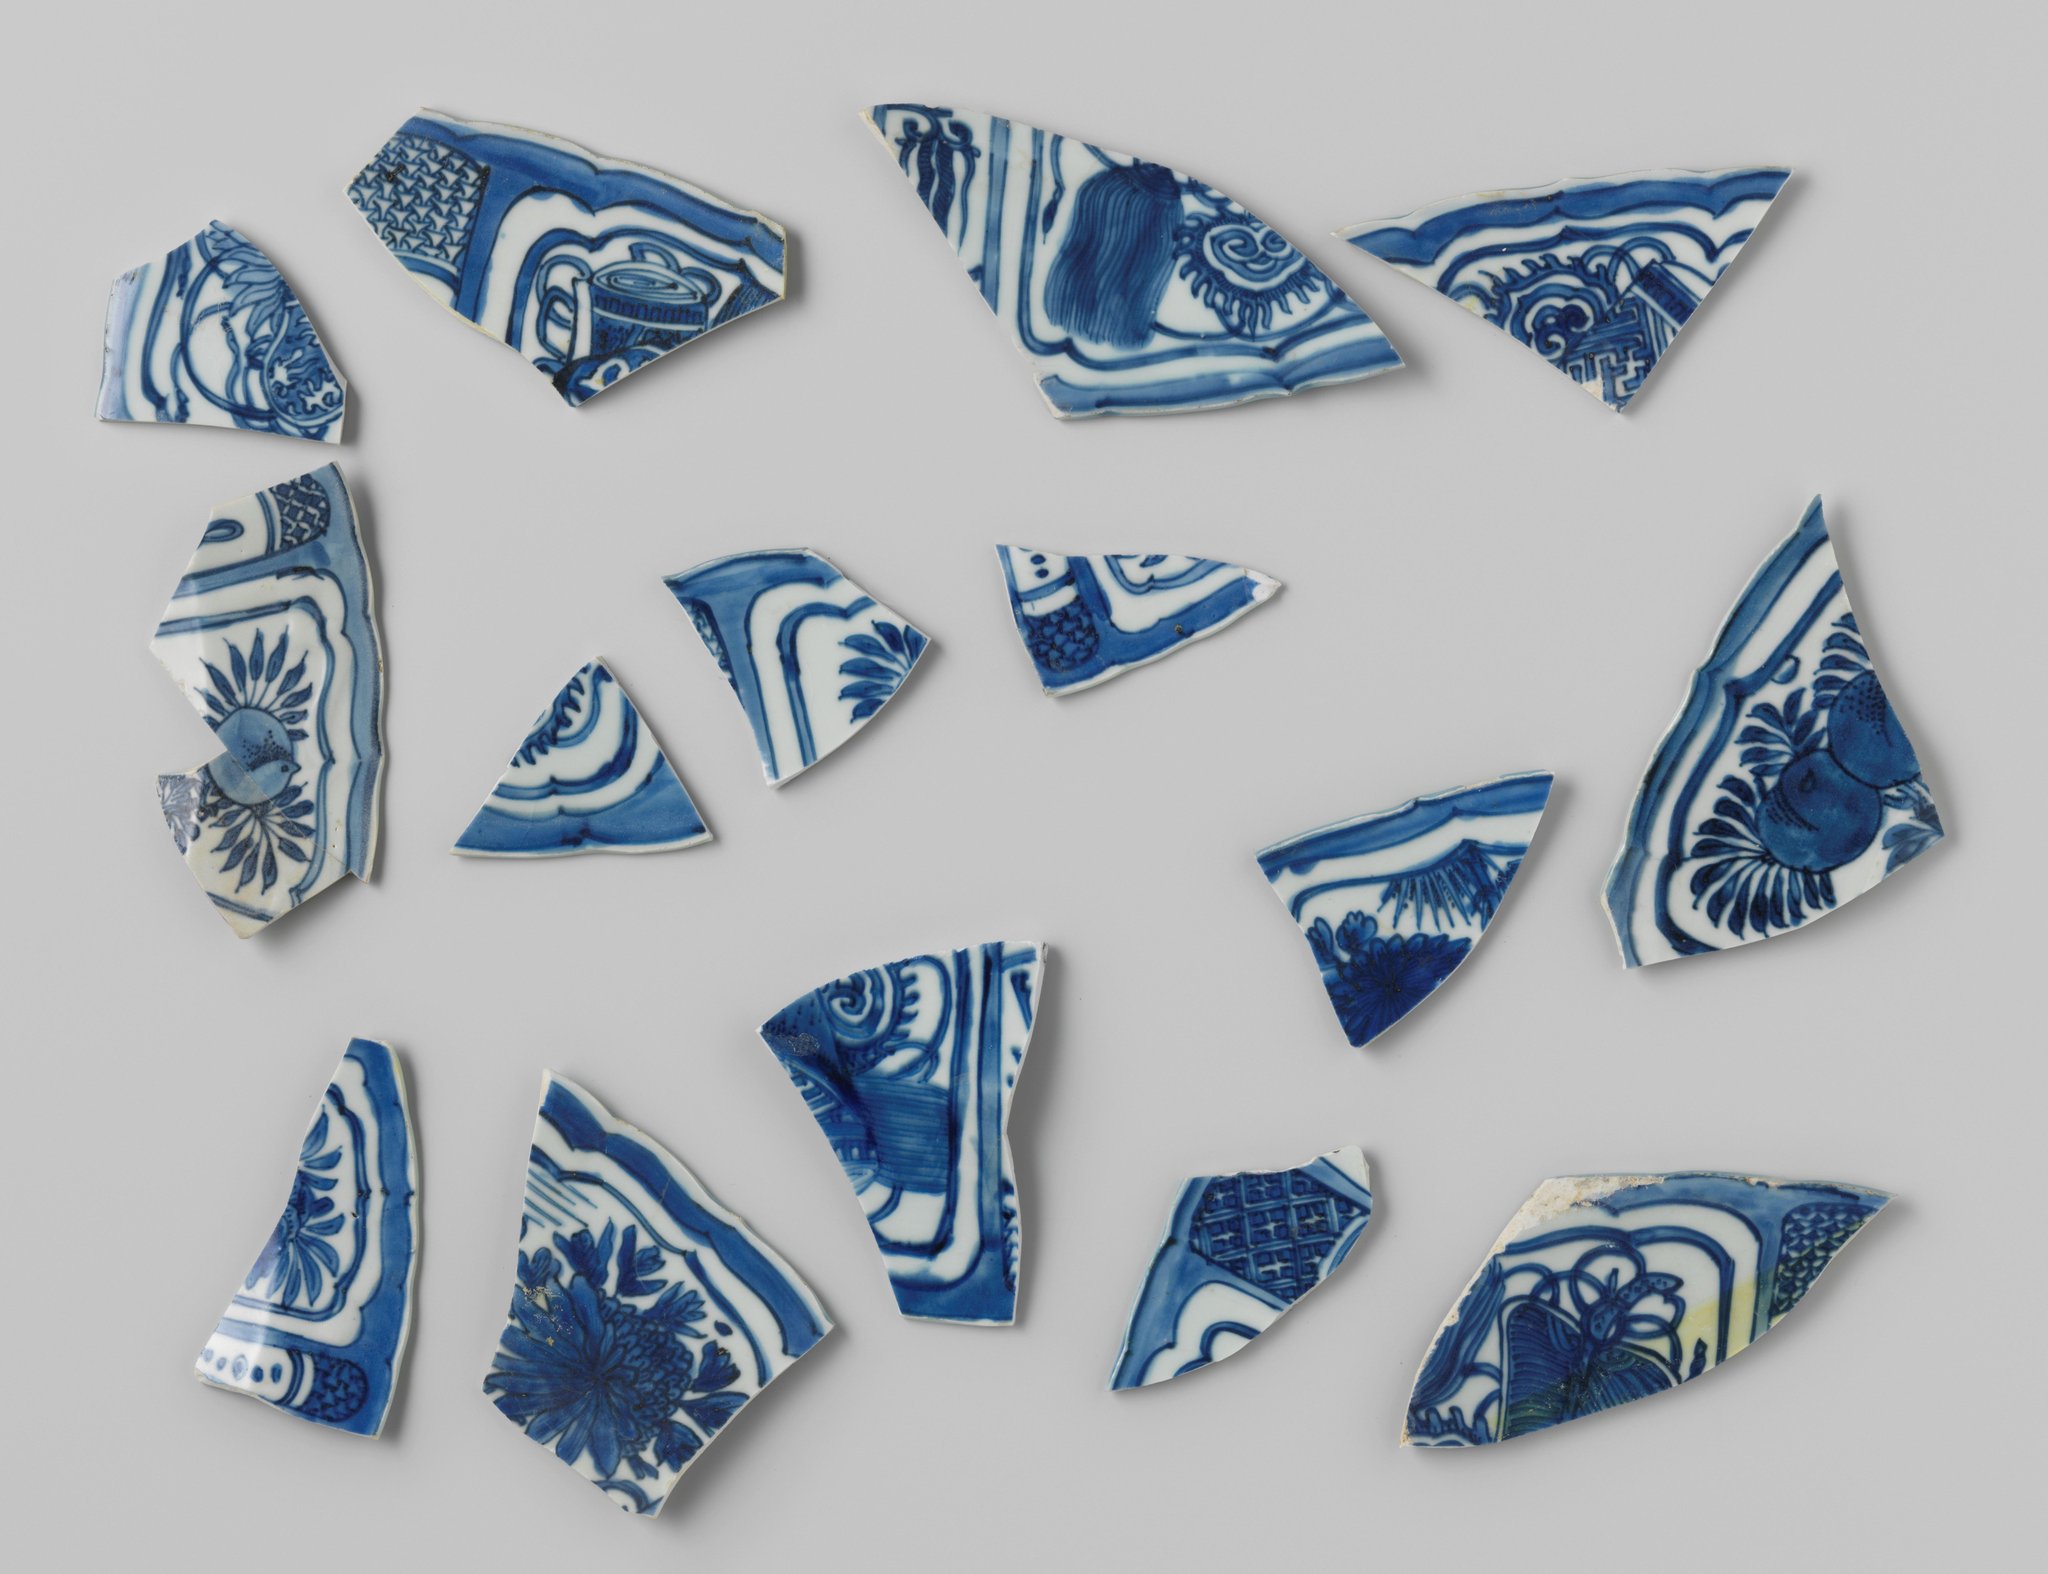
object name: sherd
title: Scherven van borden uit V.O.C.-schip de 'Witte Leeuw'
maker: Anonymous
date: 1613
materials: bone china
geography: jingdezhen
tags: verenigde oostindische compagnie, sint-helena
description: Scherven van borden kraakporselein uit V.O.C.-schip de 'Witte Leeuw'.